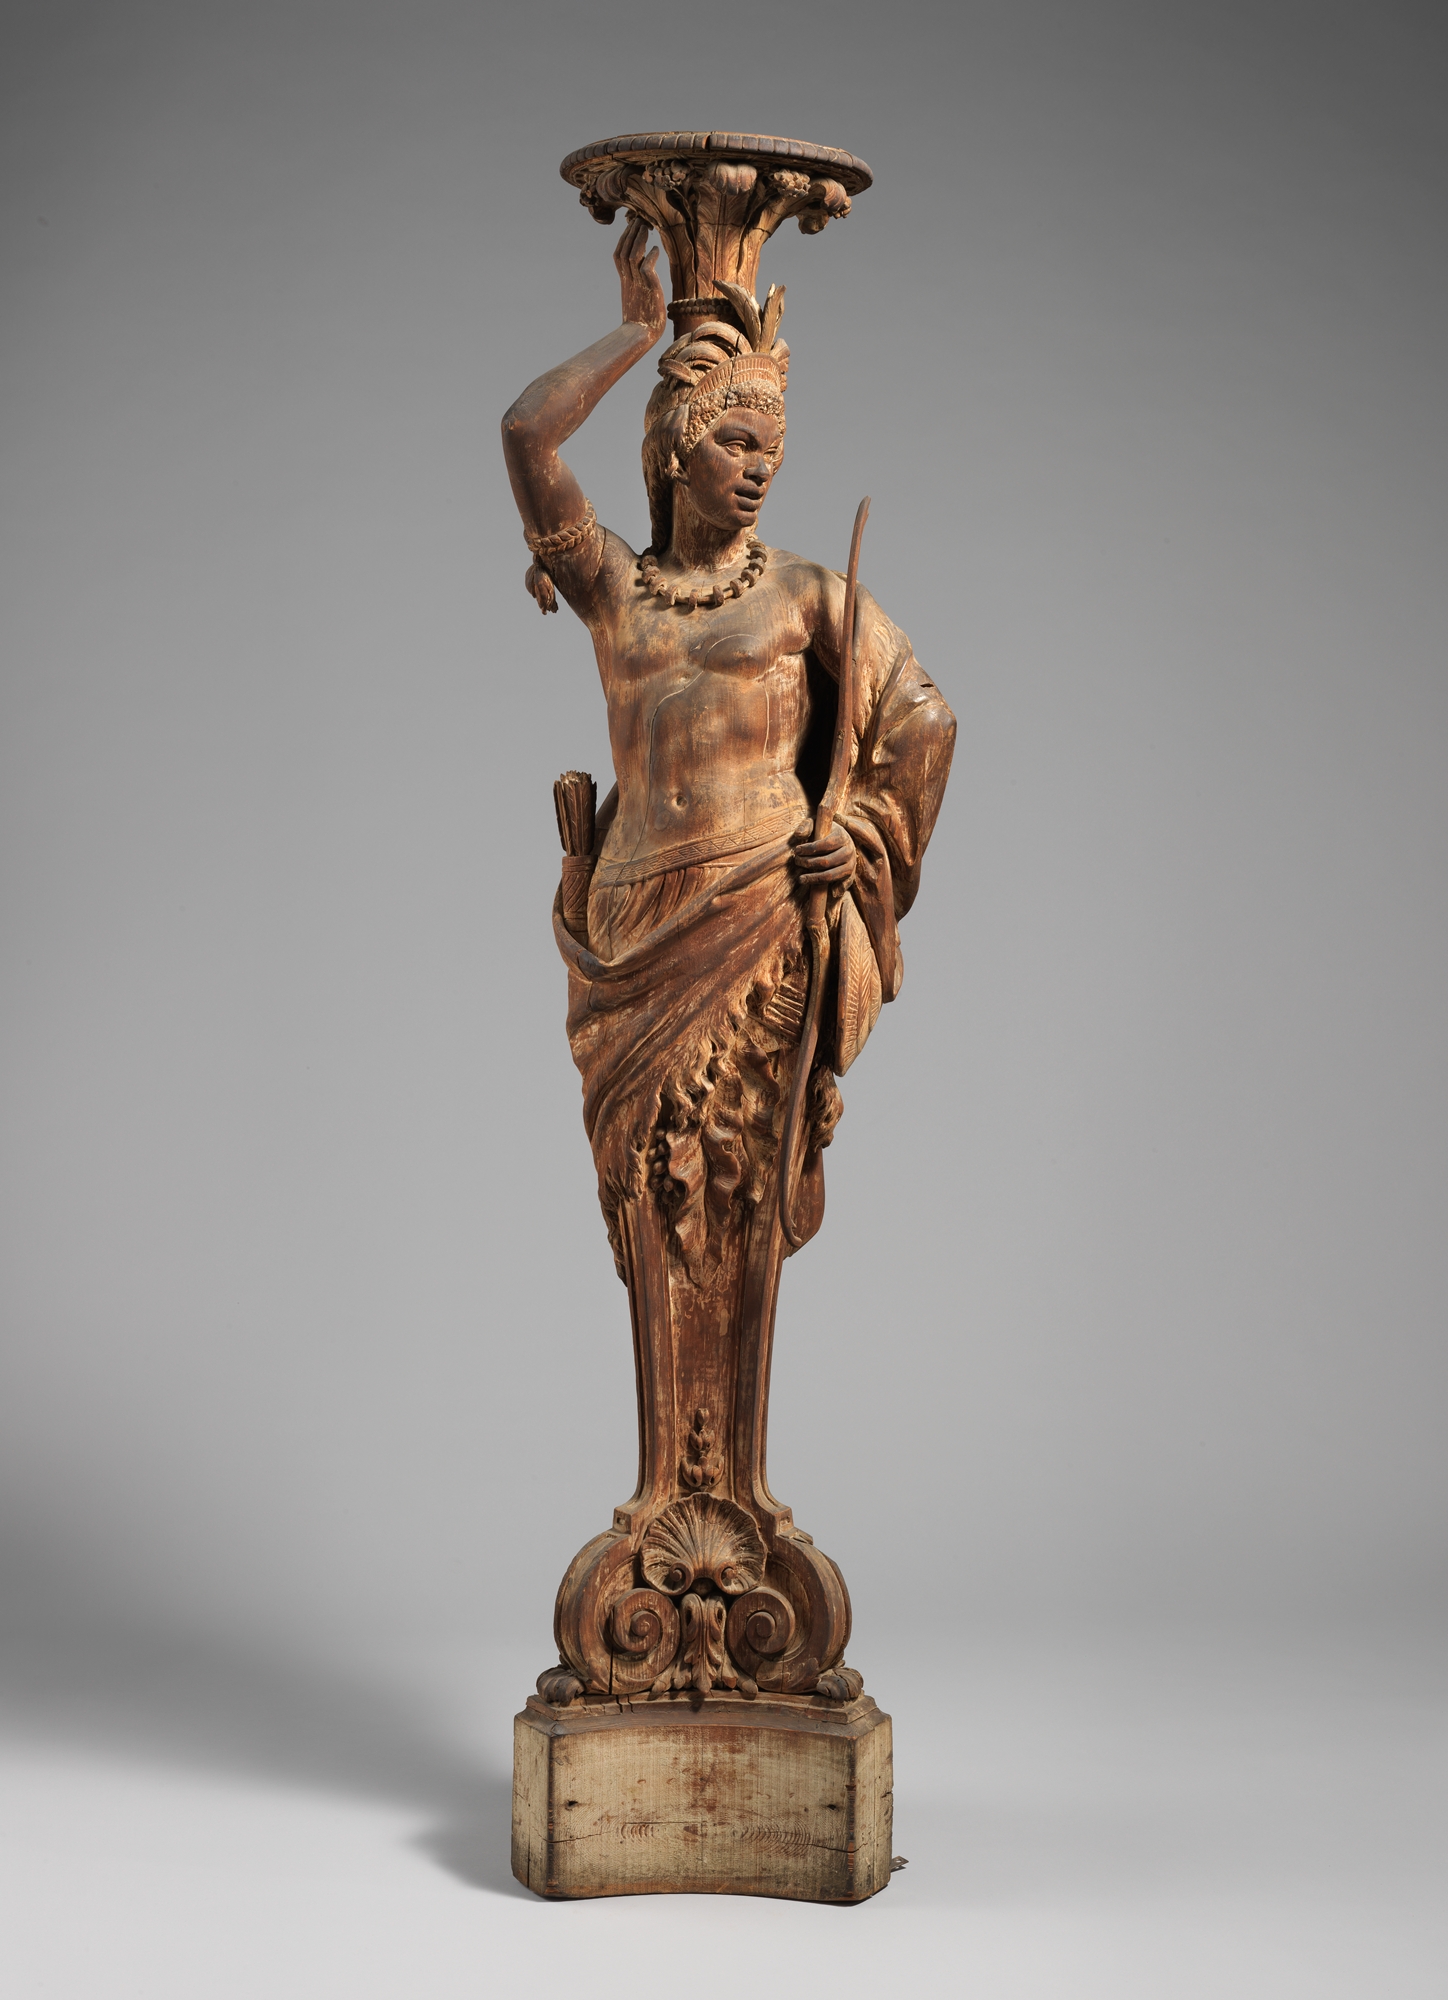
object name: candlestand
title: Candlestand (Torchère)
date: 1701-1733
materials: wood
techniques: carving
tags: men